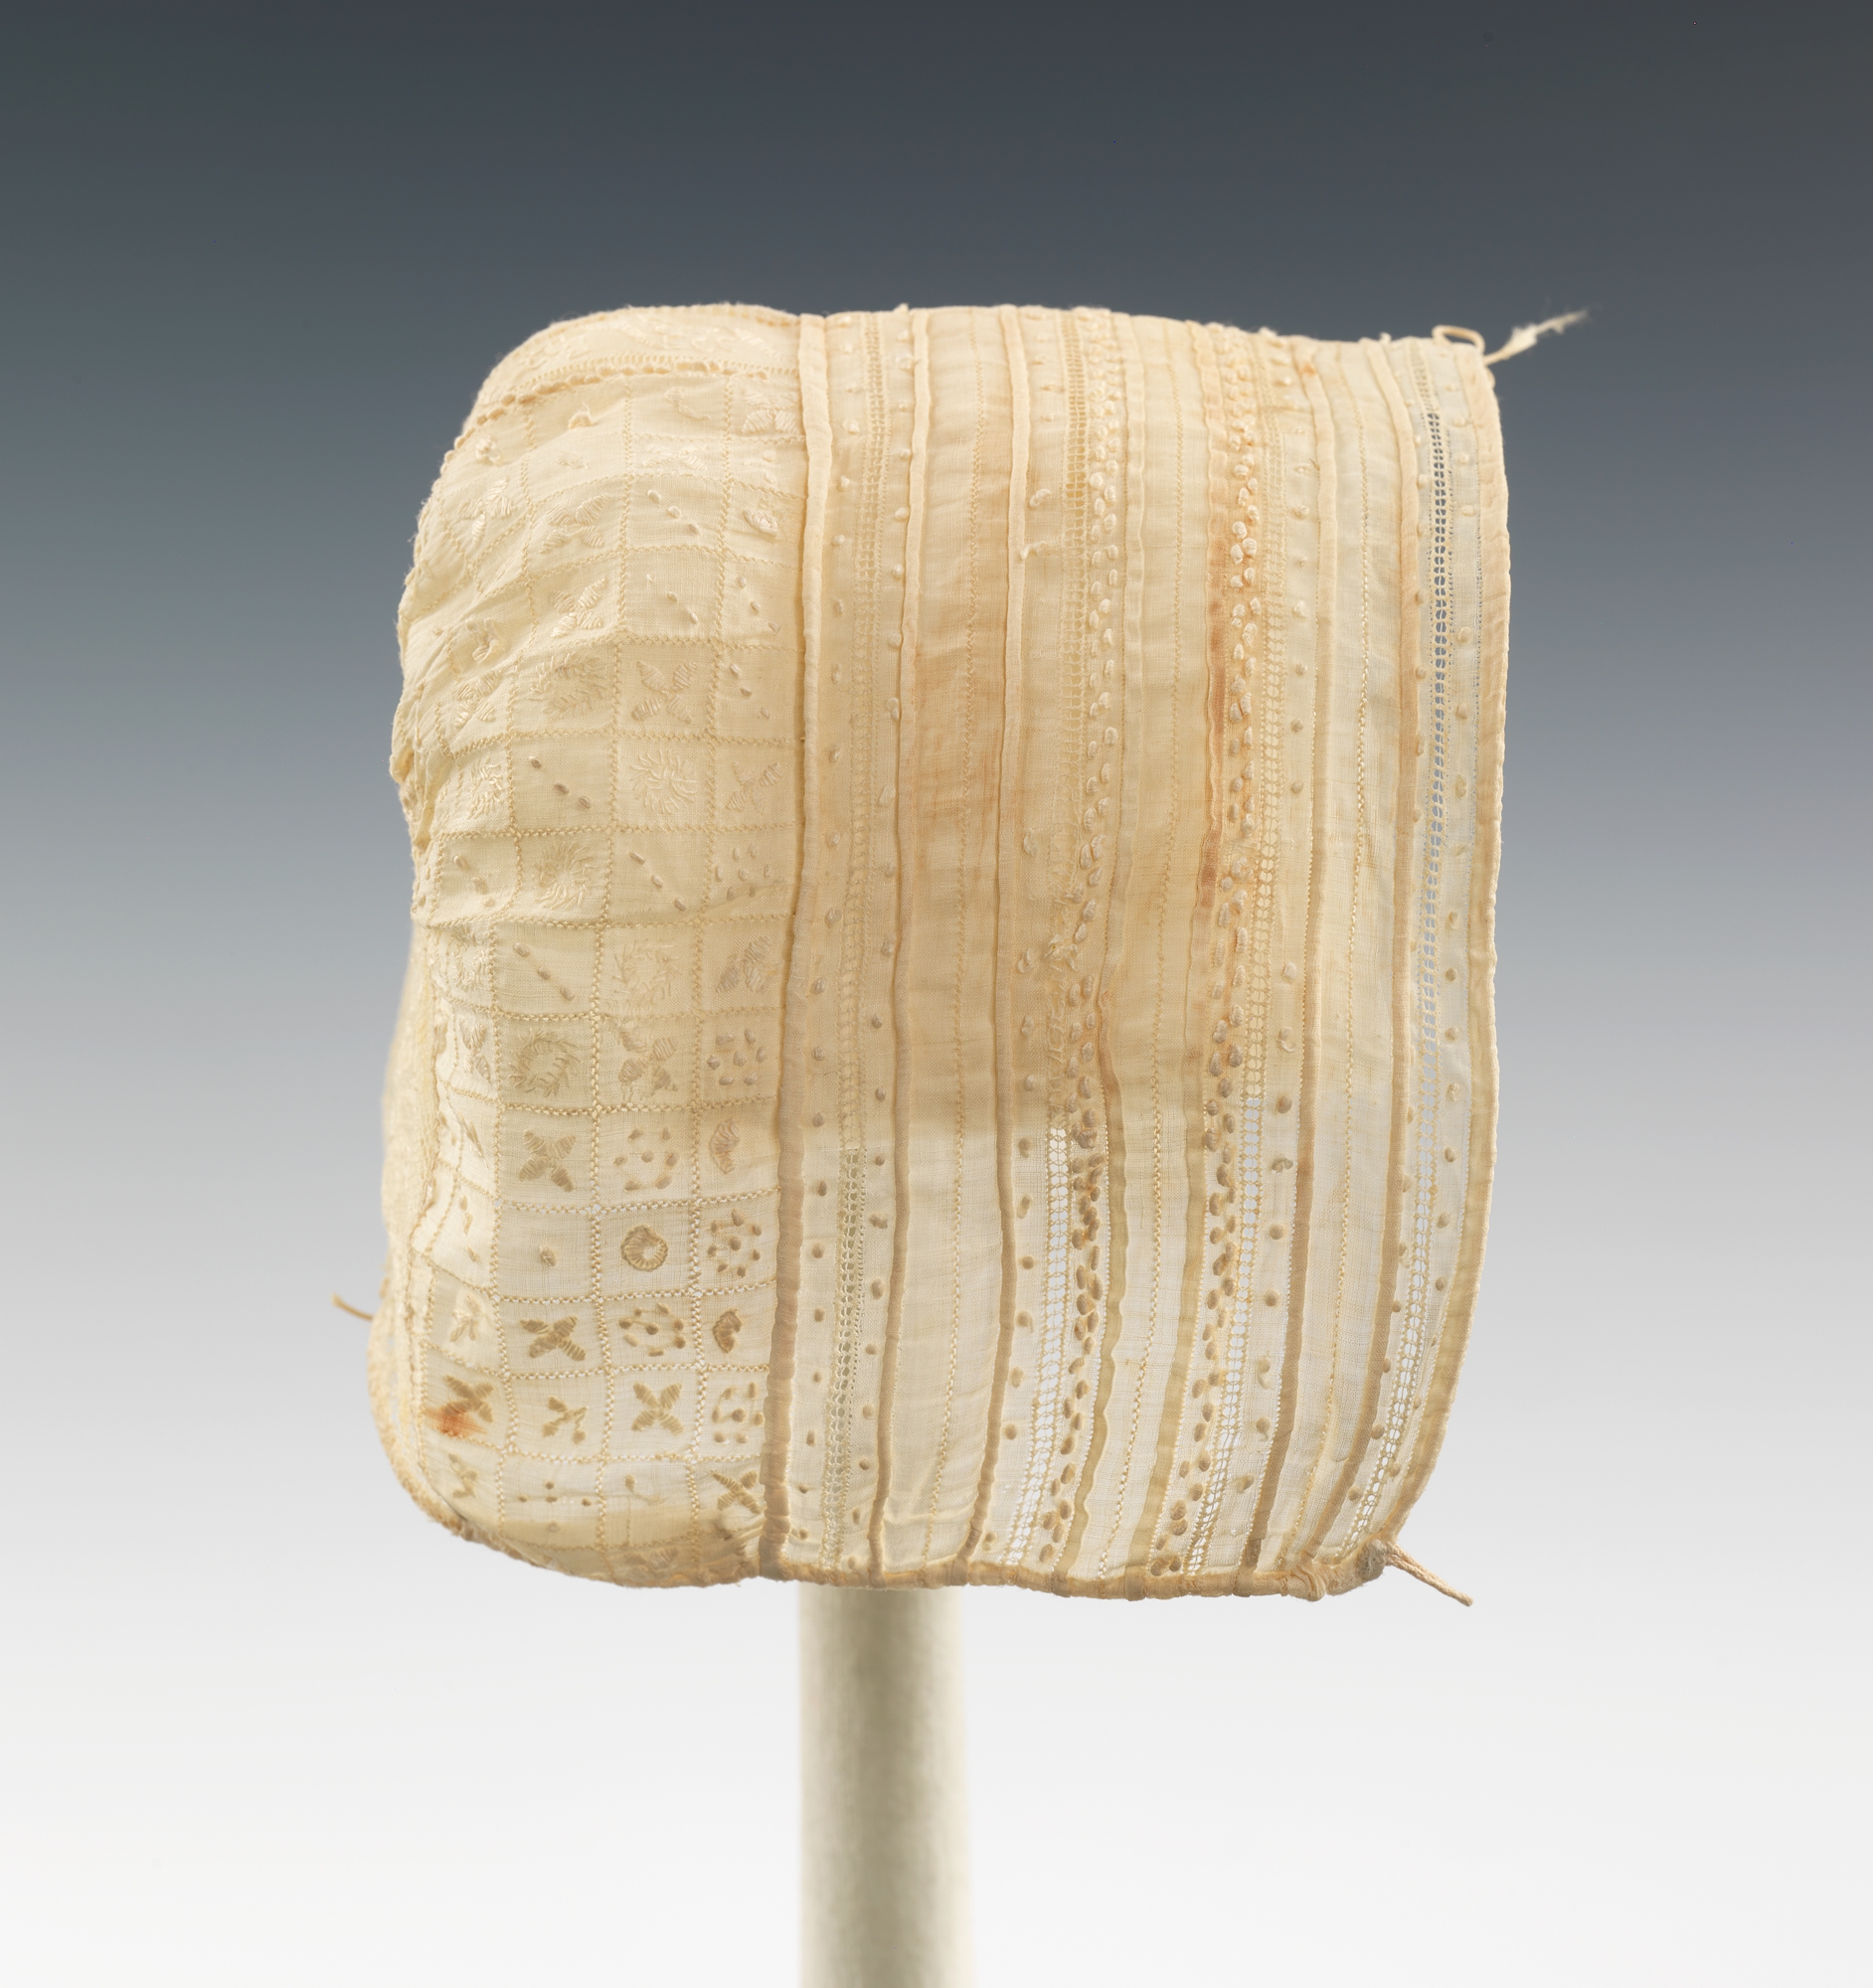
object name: cap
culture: american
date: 1835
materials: linen